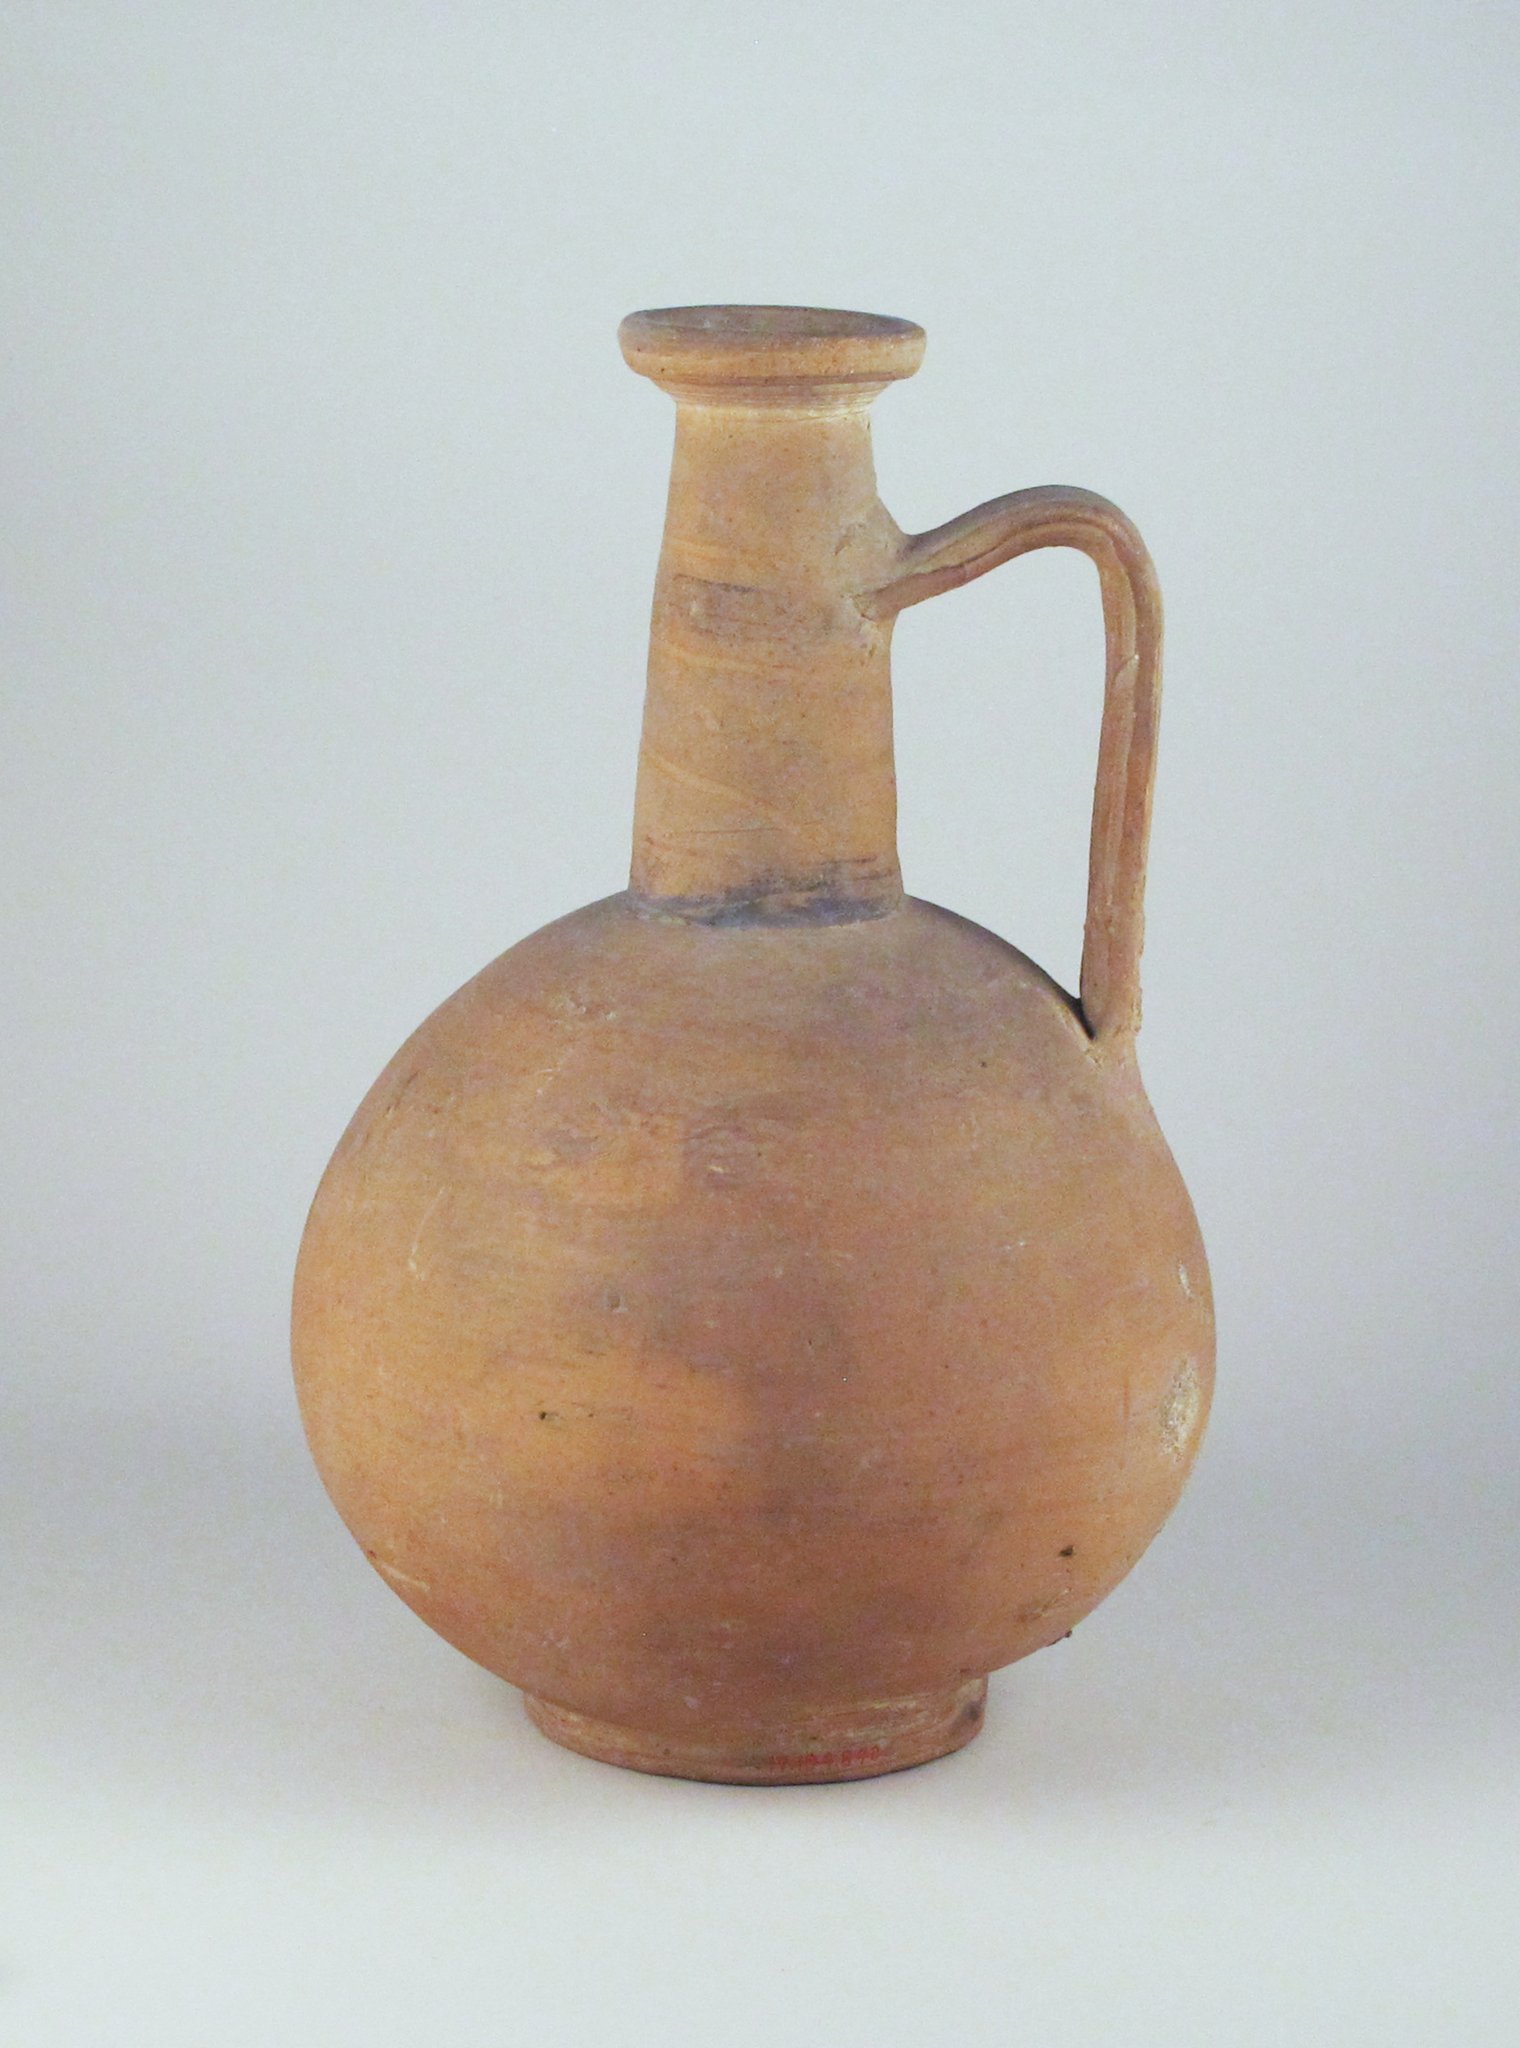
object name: jug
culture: roman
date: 670 BCE-330 CE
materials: terracotta